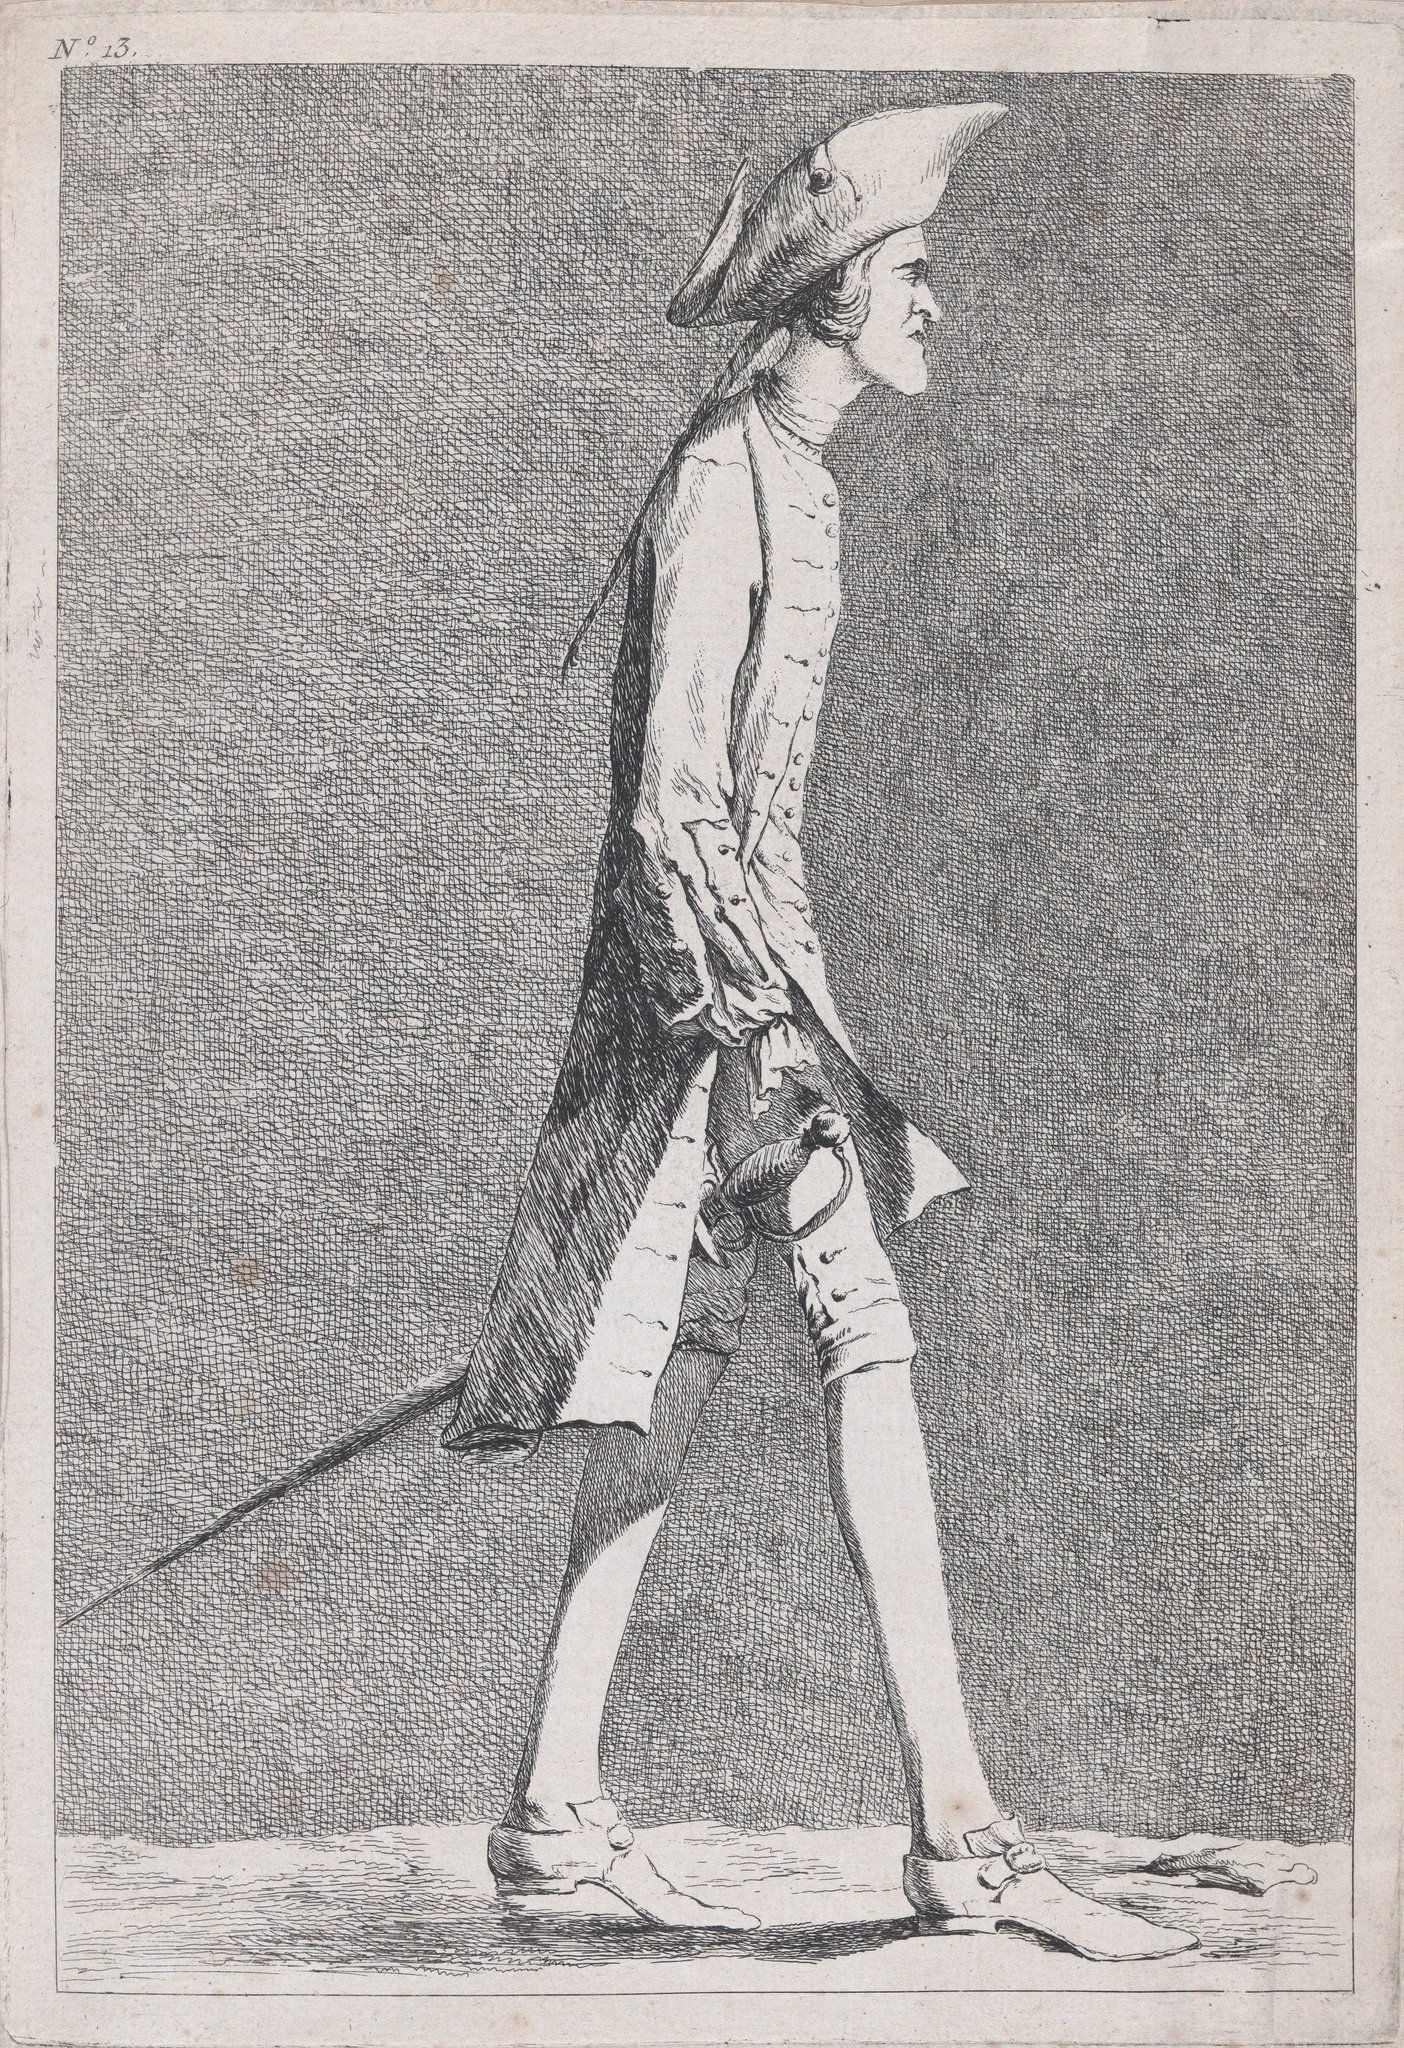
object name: print, album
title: An Artist at the French Academy in Rome (?), pl. XIII from "Recueil de caricatures"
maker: ange-laurent de la live de jully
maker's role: artist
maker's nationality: french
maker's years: 1725-1779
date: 1754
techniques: etching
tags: men,caricature